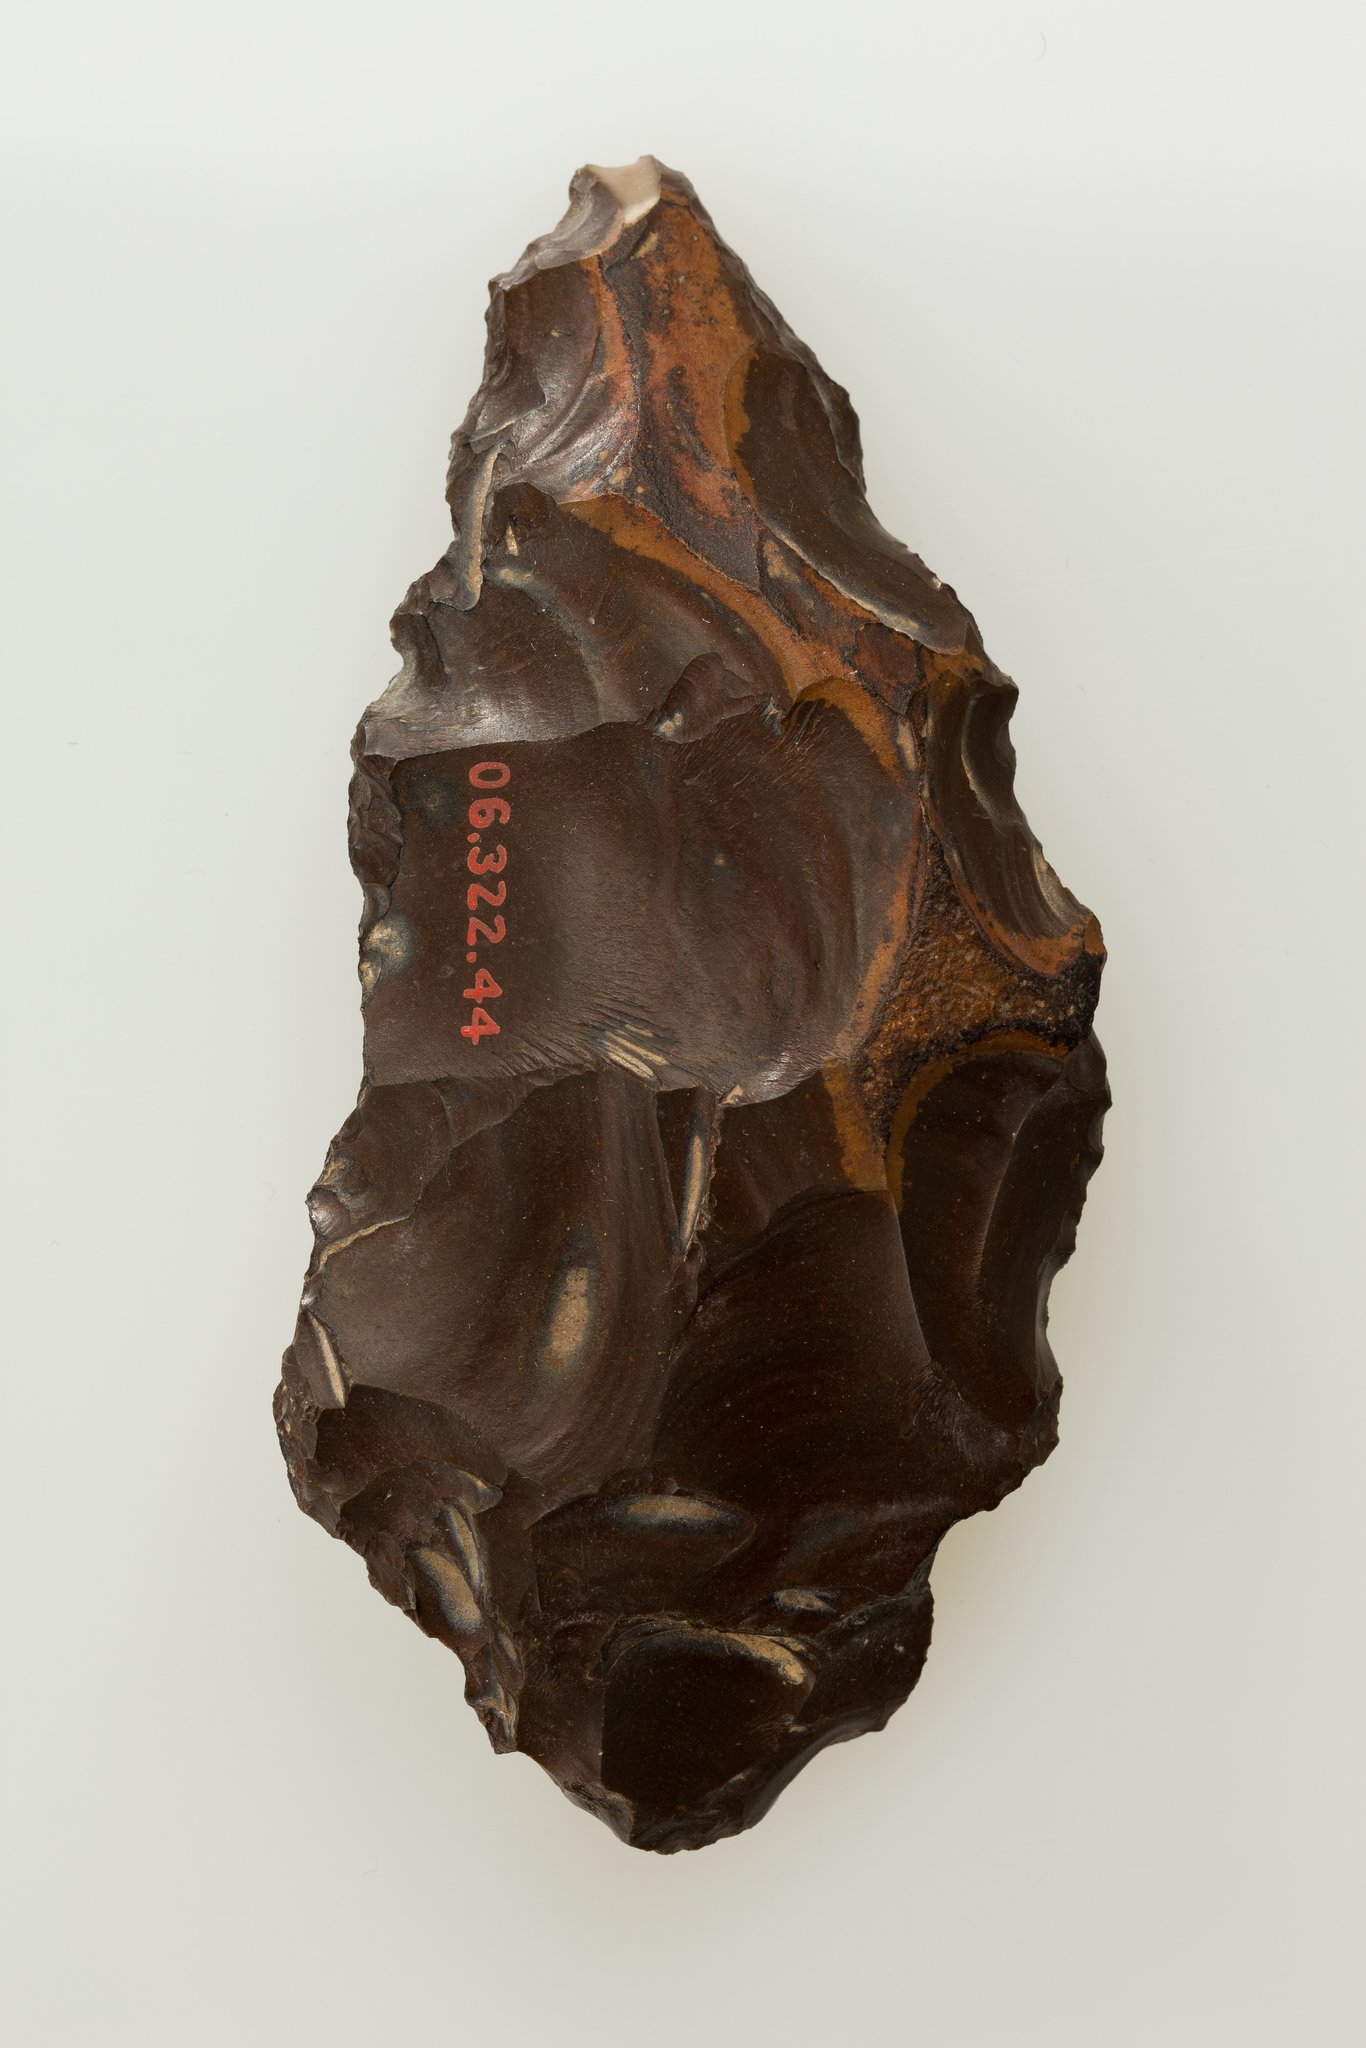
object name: tool, biface, hand ax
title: Biface, commonly referred to as a hand ax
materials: stone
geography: egypt